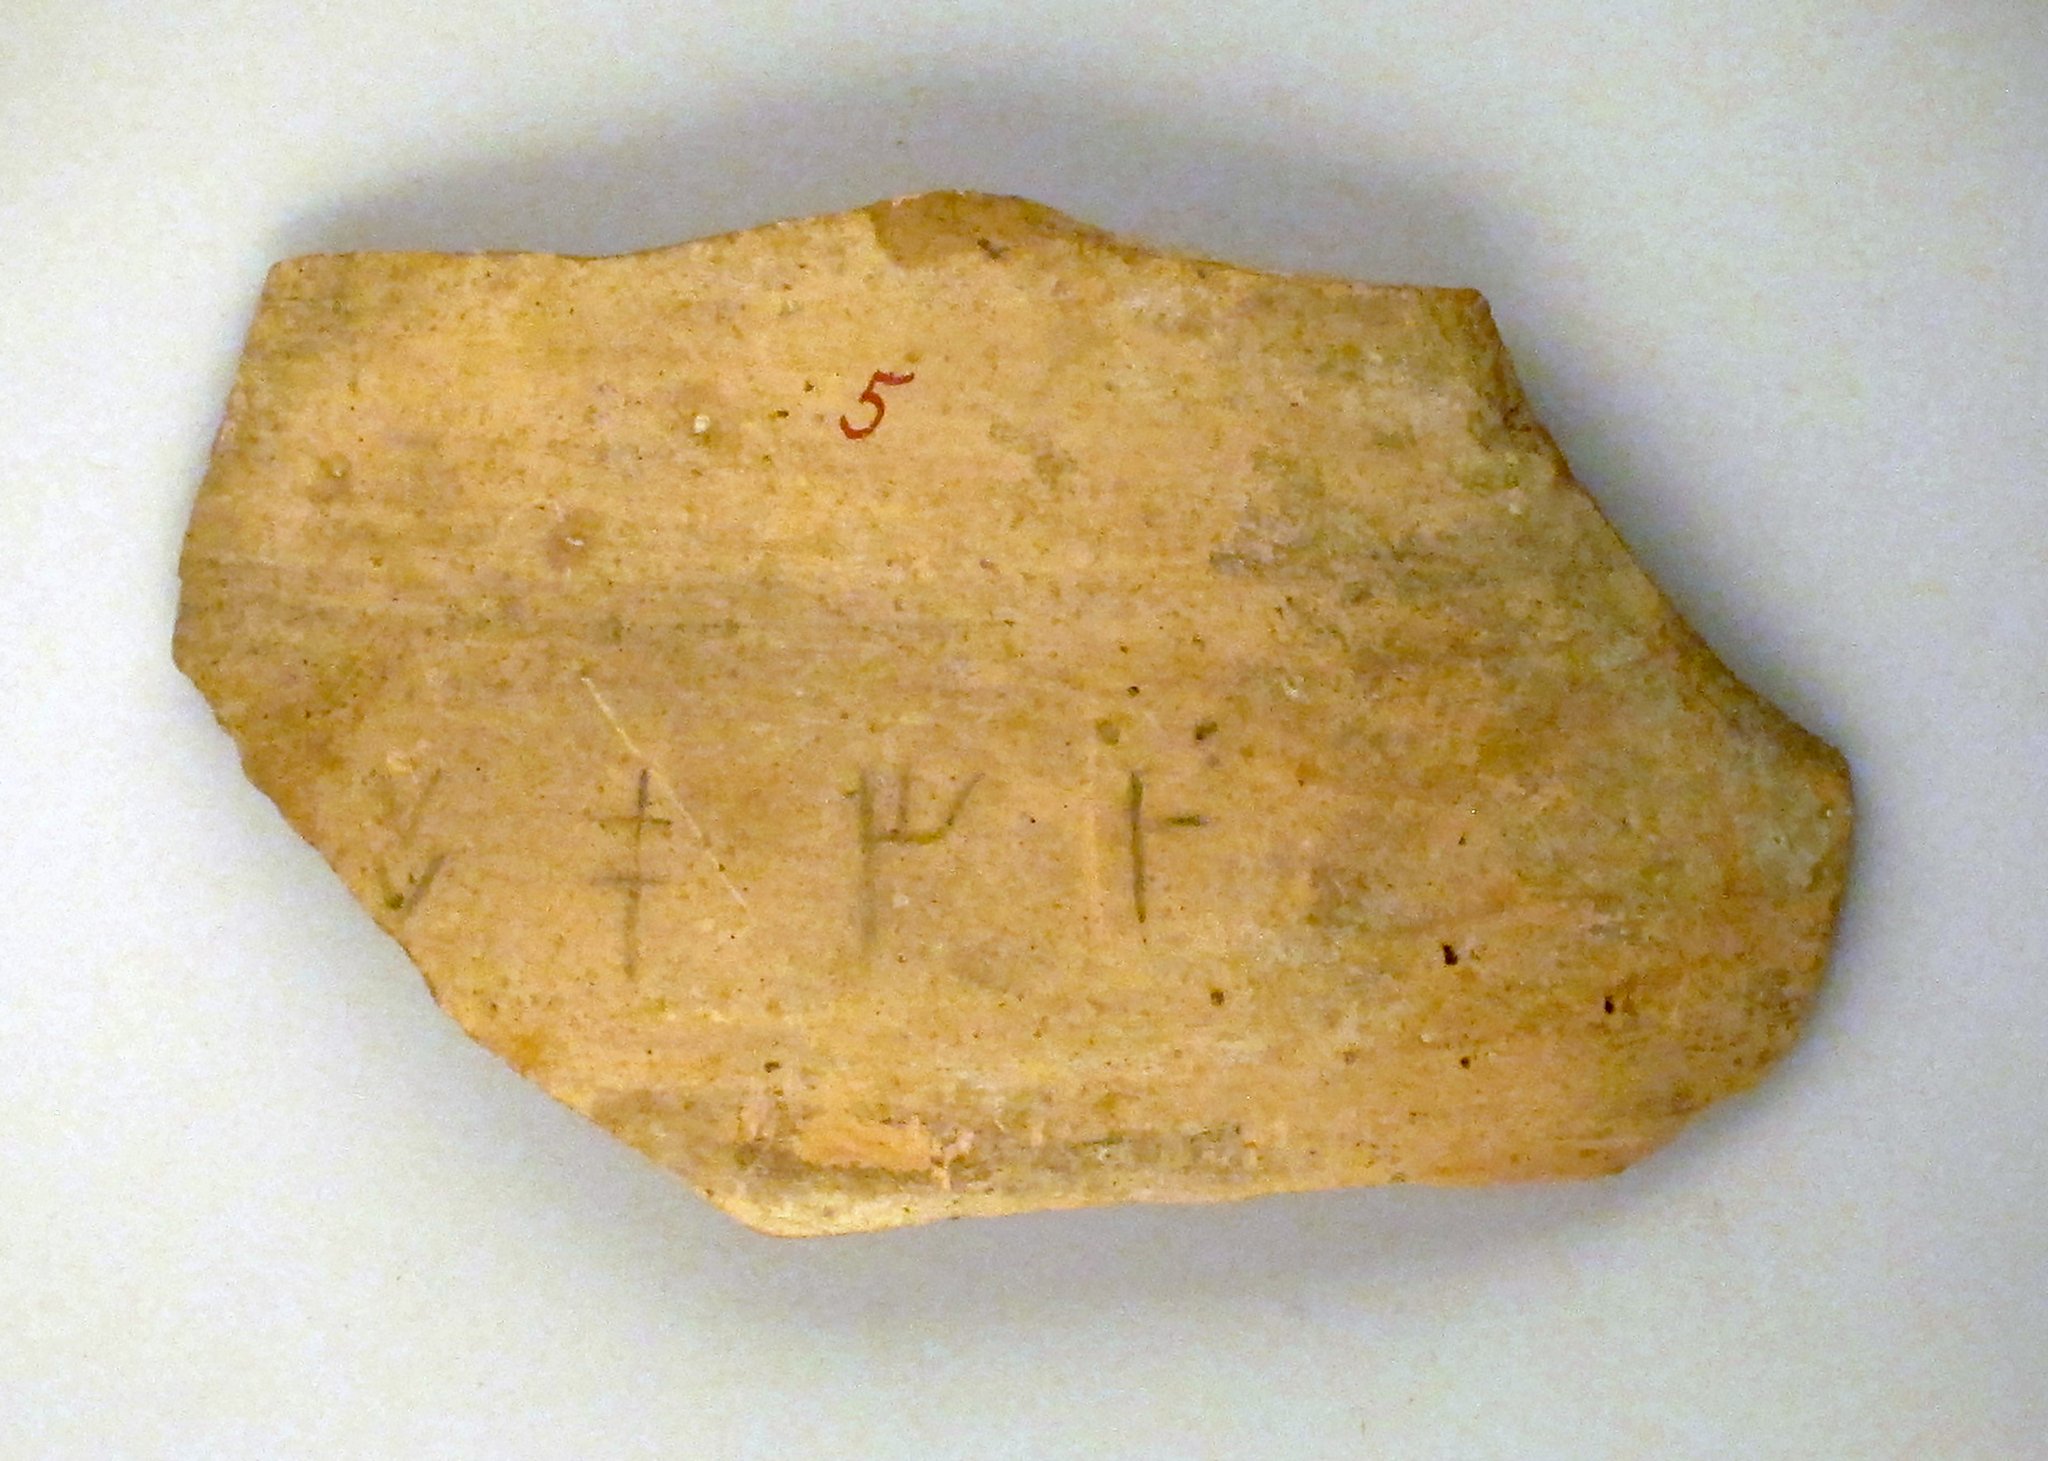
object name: vase fragment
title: Terracotta vase fragment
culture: cypriot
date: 3900 BCE-100 CE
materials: clay